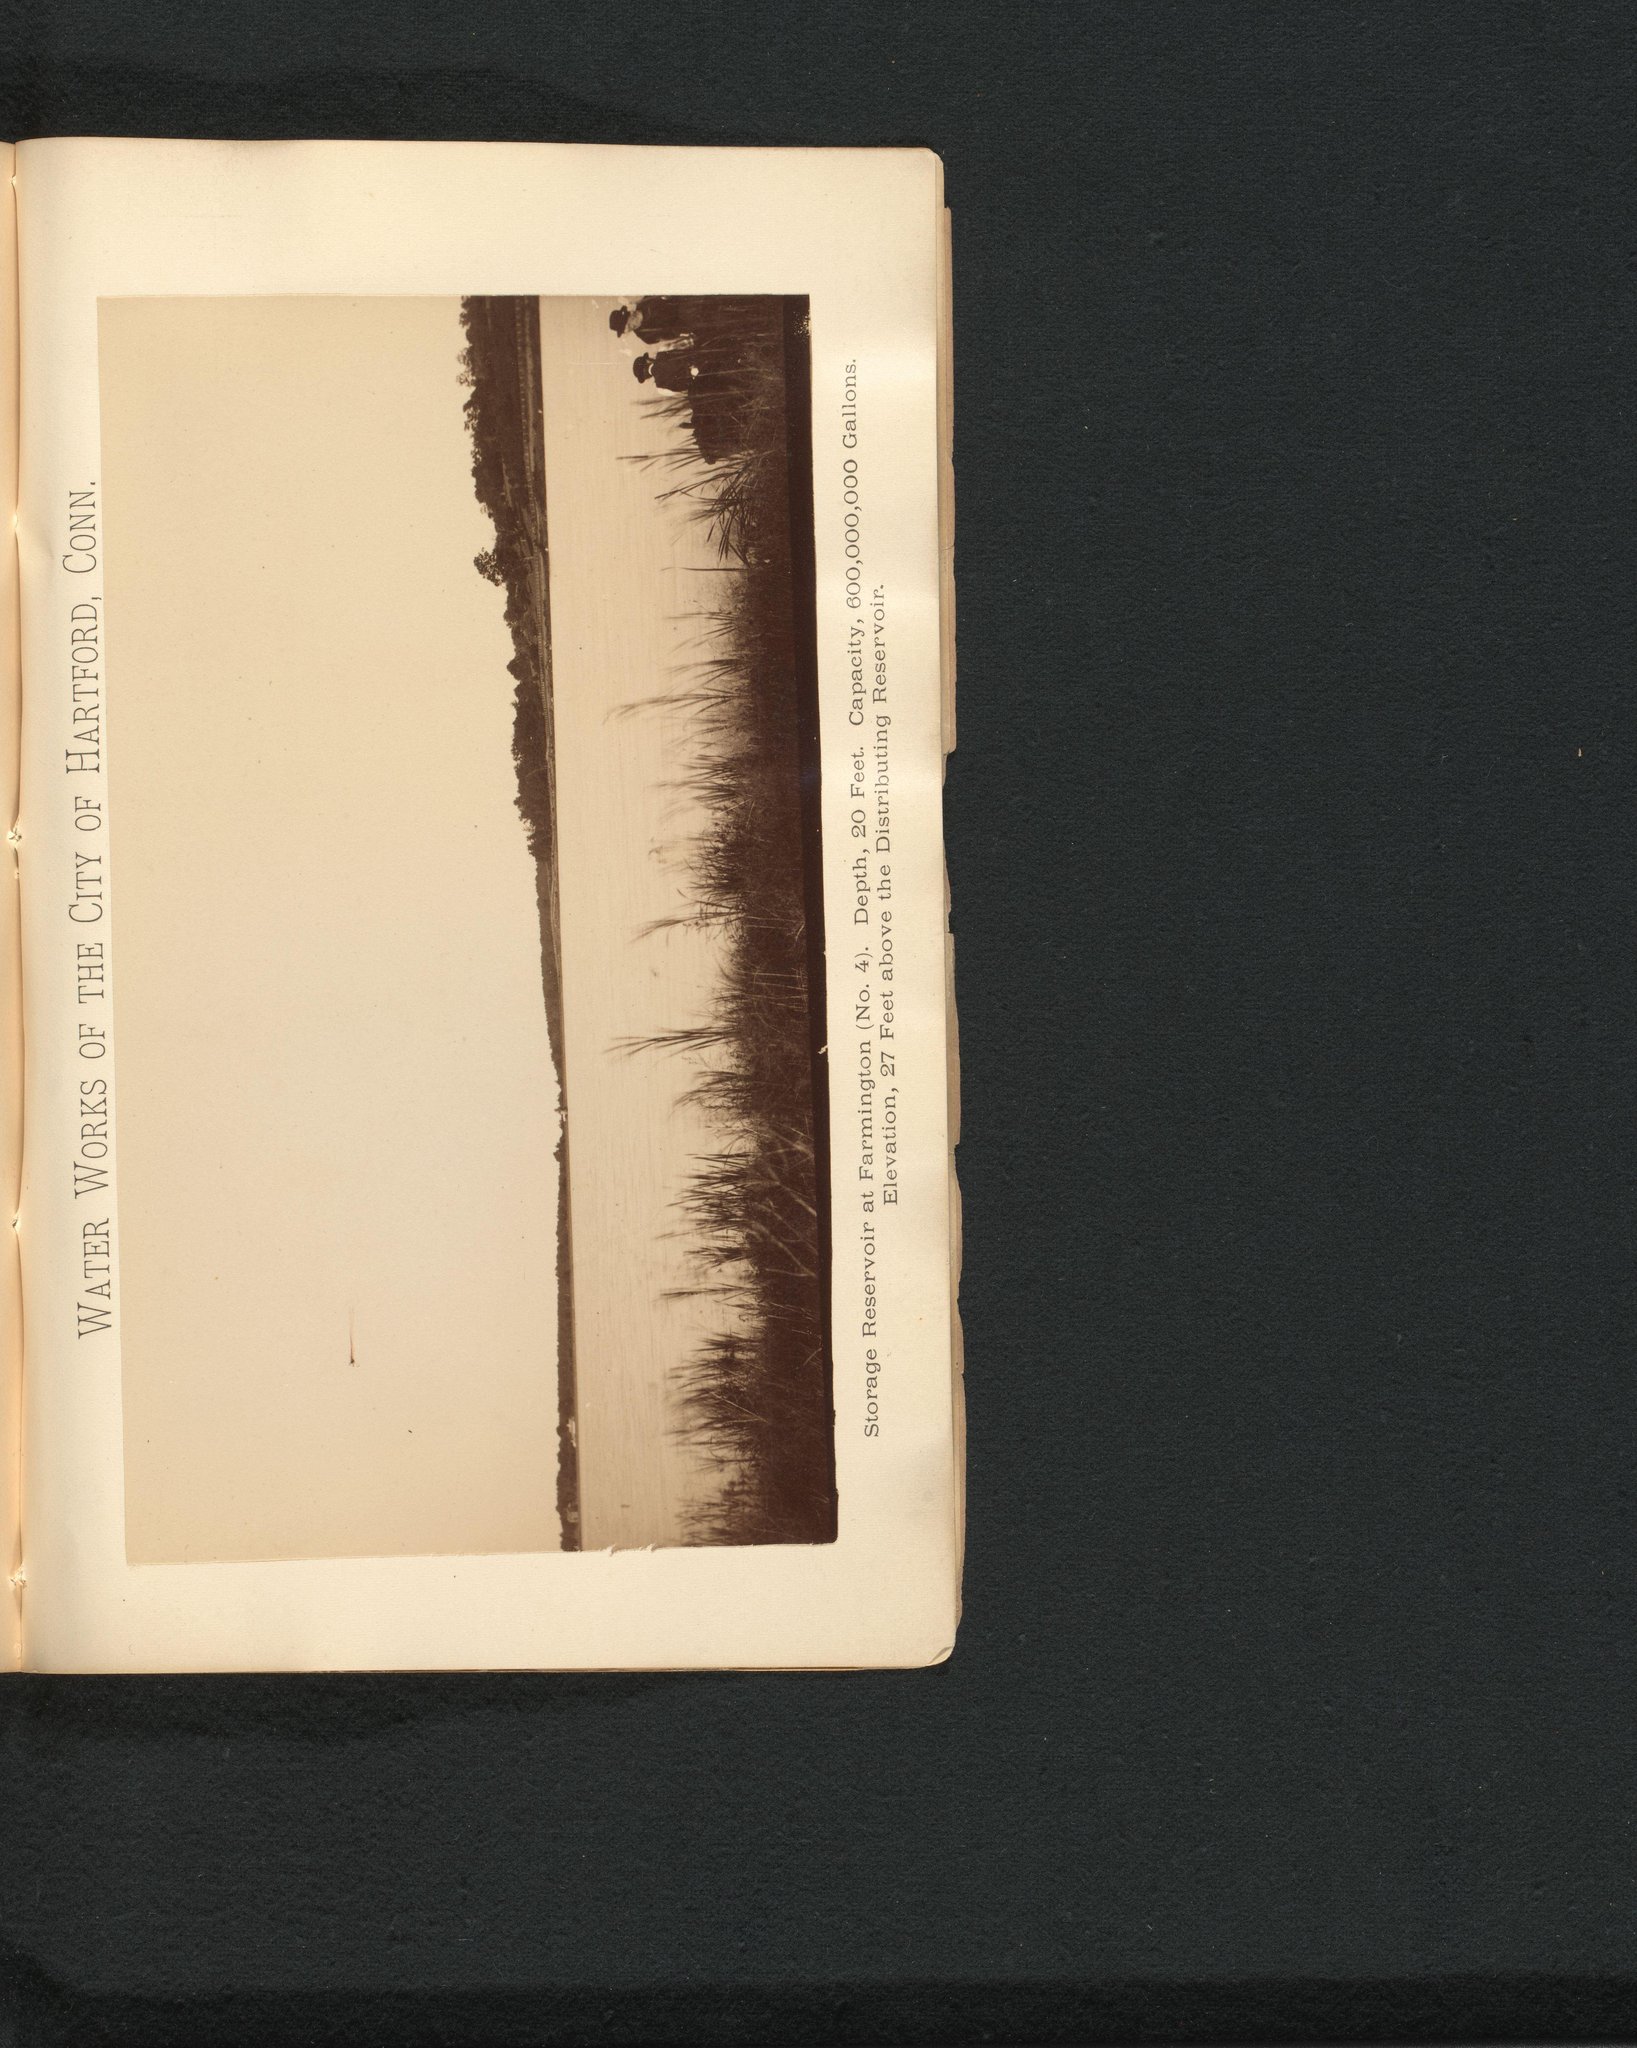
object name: page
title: Storage reservoir at West Hartford (no. 4). Depth, 20 feet. Capacity 600,000,000 gallons. Elevation, 27 feet above Connecticut river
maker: Anonymous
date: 1883-1884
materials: photographic support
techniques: albumen print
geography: connecticut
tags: water course